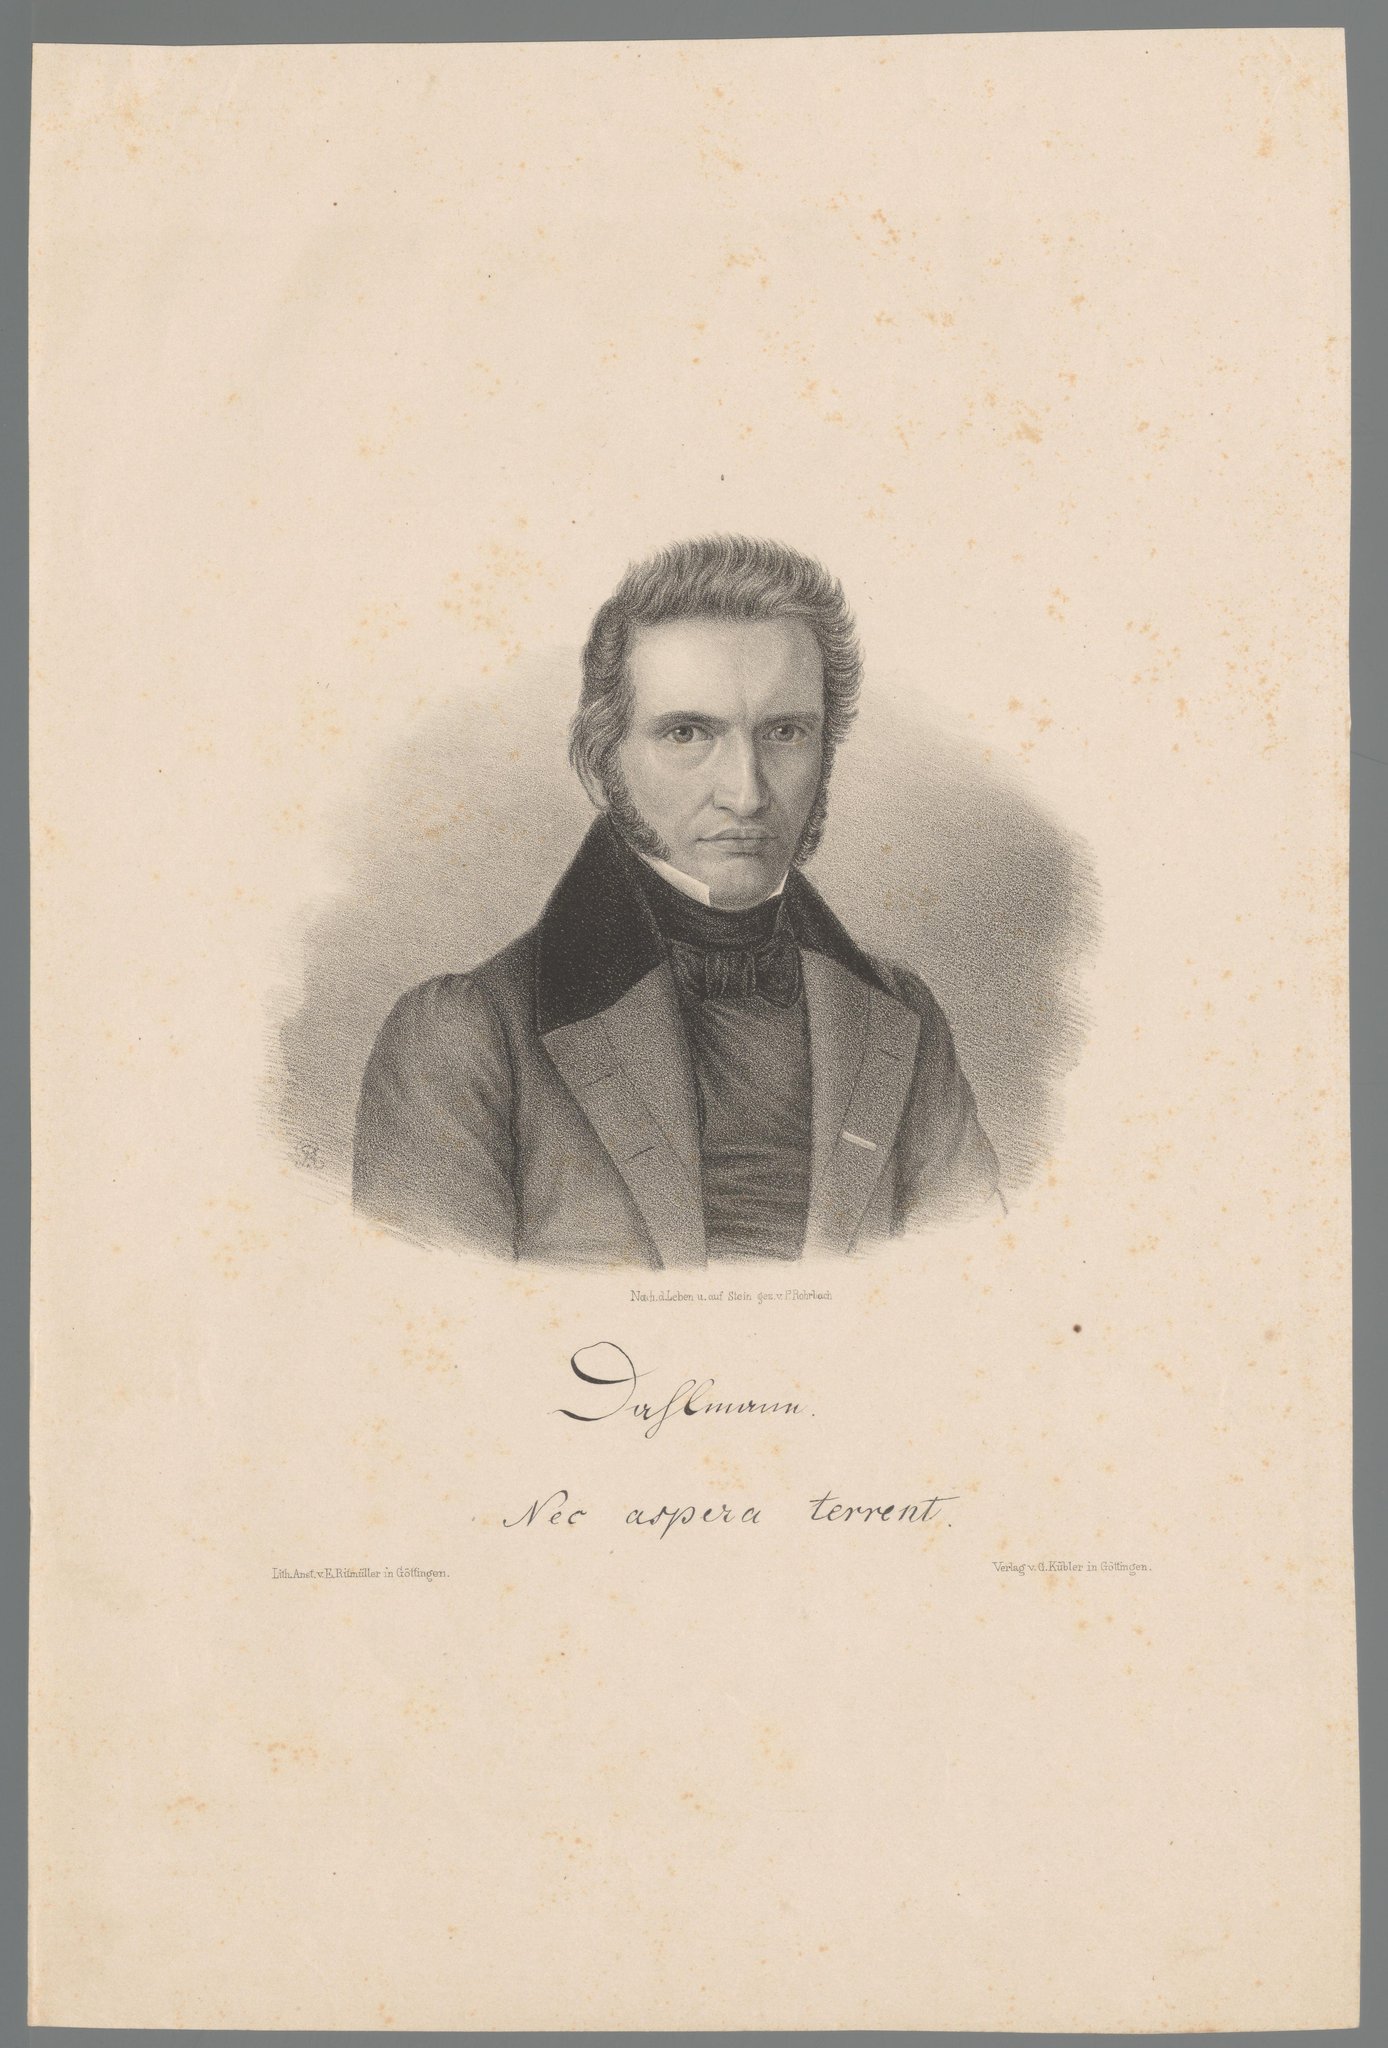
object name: print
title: Portret van Friedrich Christoph Dahlmann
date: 1827-1862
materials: paper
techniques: lithograph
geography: gottingen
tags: politician, historical persons, politician, e.g. party leader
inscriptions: collector's mark: Lugt 2228